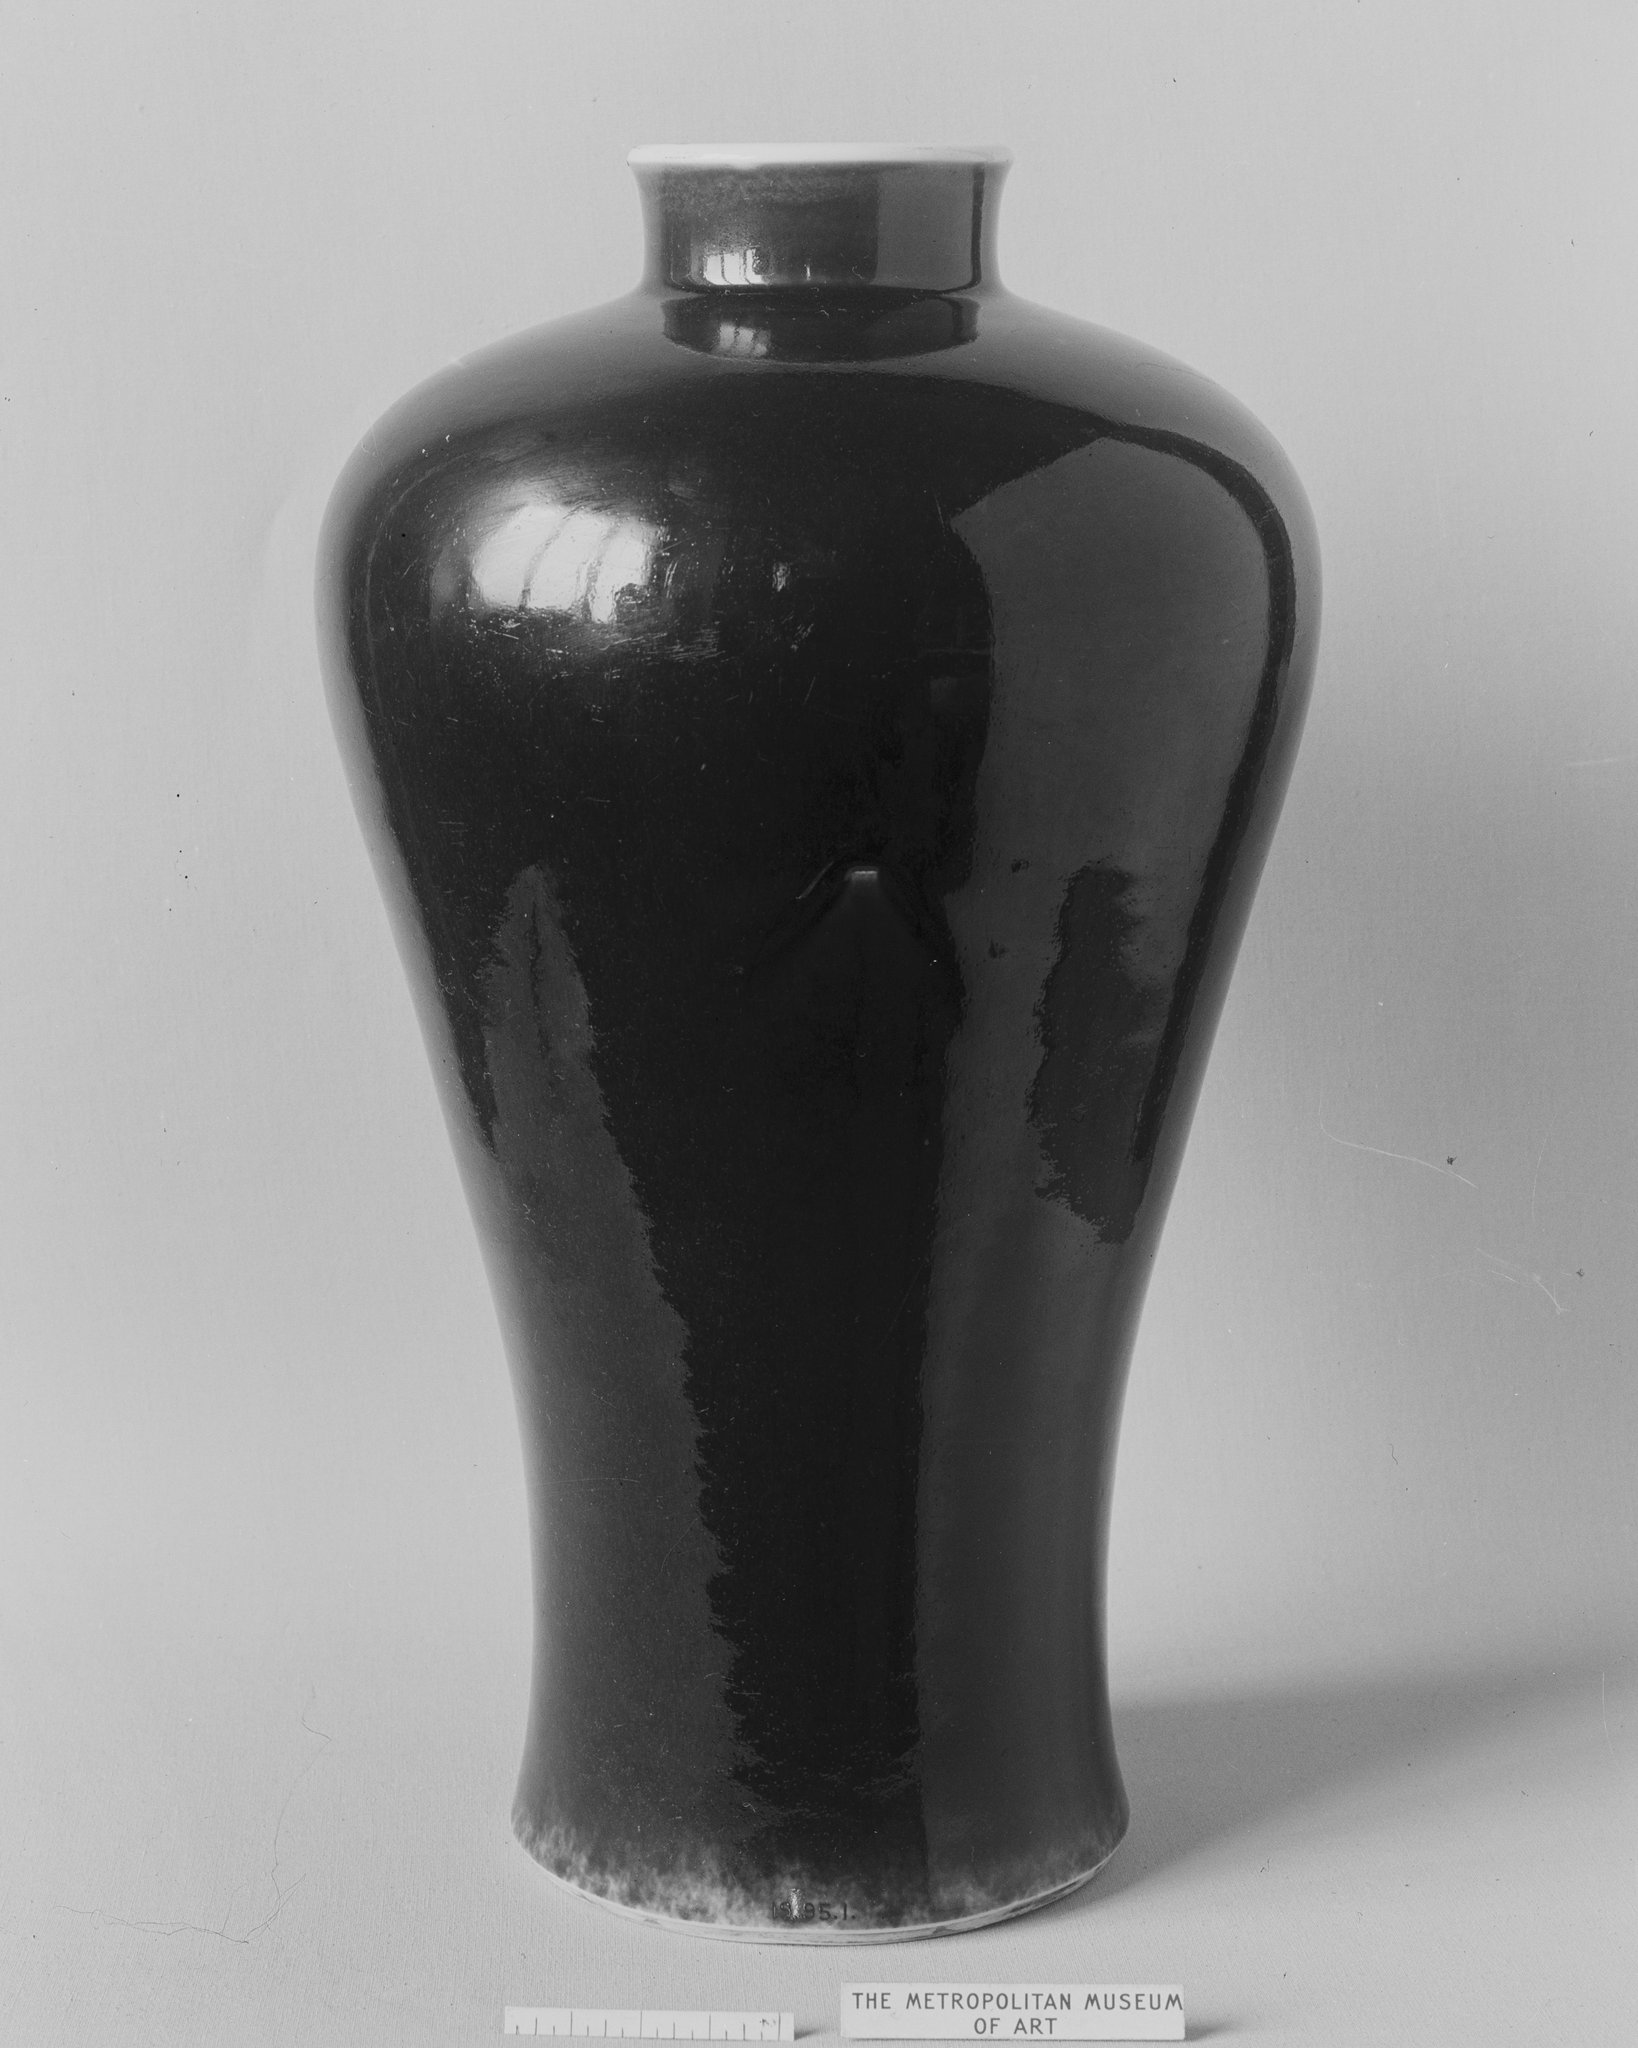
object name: vase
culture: chinese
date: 1736-1795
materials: porcelain